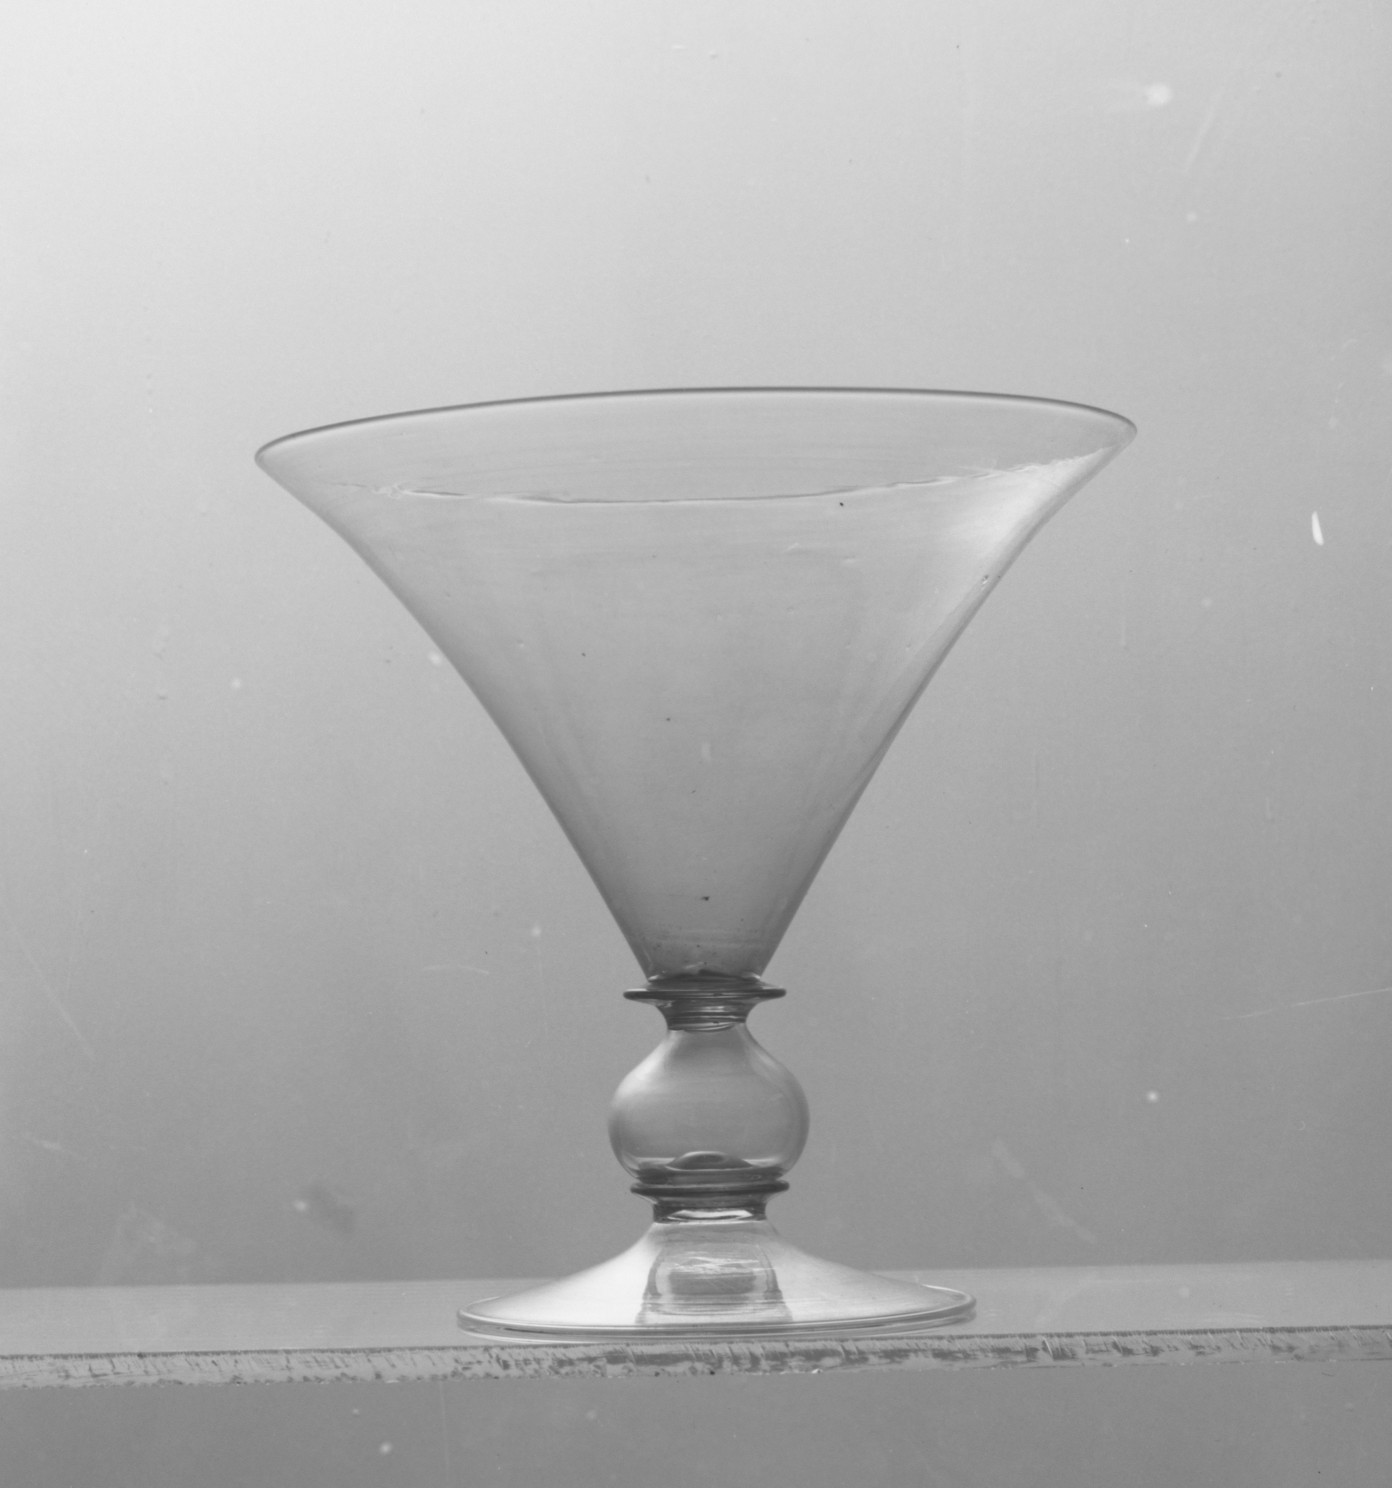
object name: wineglass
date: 1601-1700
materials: glass